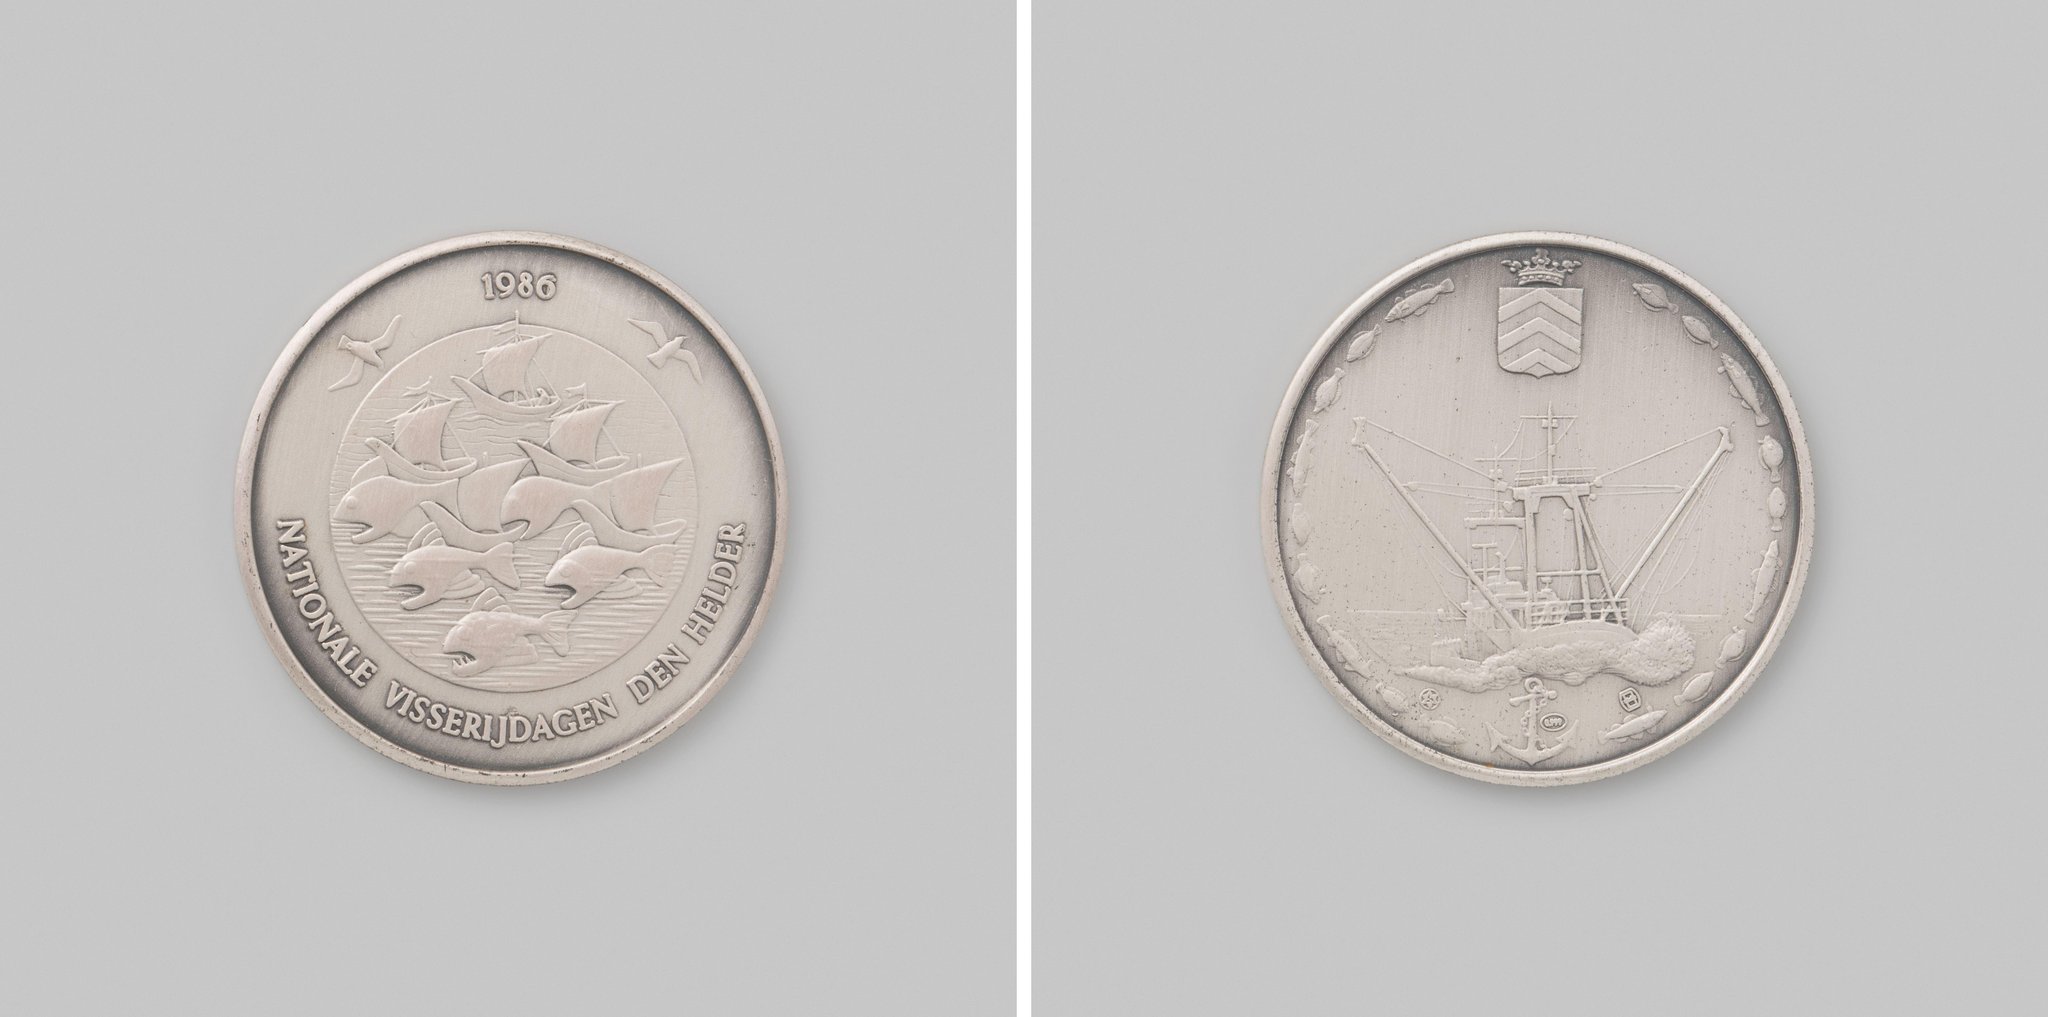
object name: history medal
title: Nationale Visserijdagen te Den Helder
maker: Anonymous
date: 1986-1988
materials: alloy, plastic, silk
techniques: striking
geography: netherlands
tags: den helder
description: Penning. Voorzijde: vissen en schepen op zee binnen omschrift. Keerzijde: vissersboot op zee onder gekroond wapenschild boven anker binnen rand van vissen; bijbehorend blauw doosje van kunststof, waarvan binnenzijde deksel bekleed is met witte zijde en binnenzijde bodem met blauwe stof, waarin ronde uitsparing is opengelaten